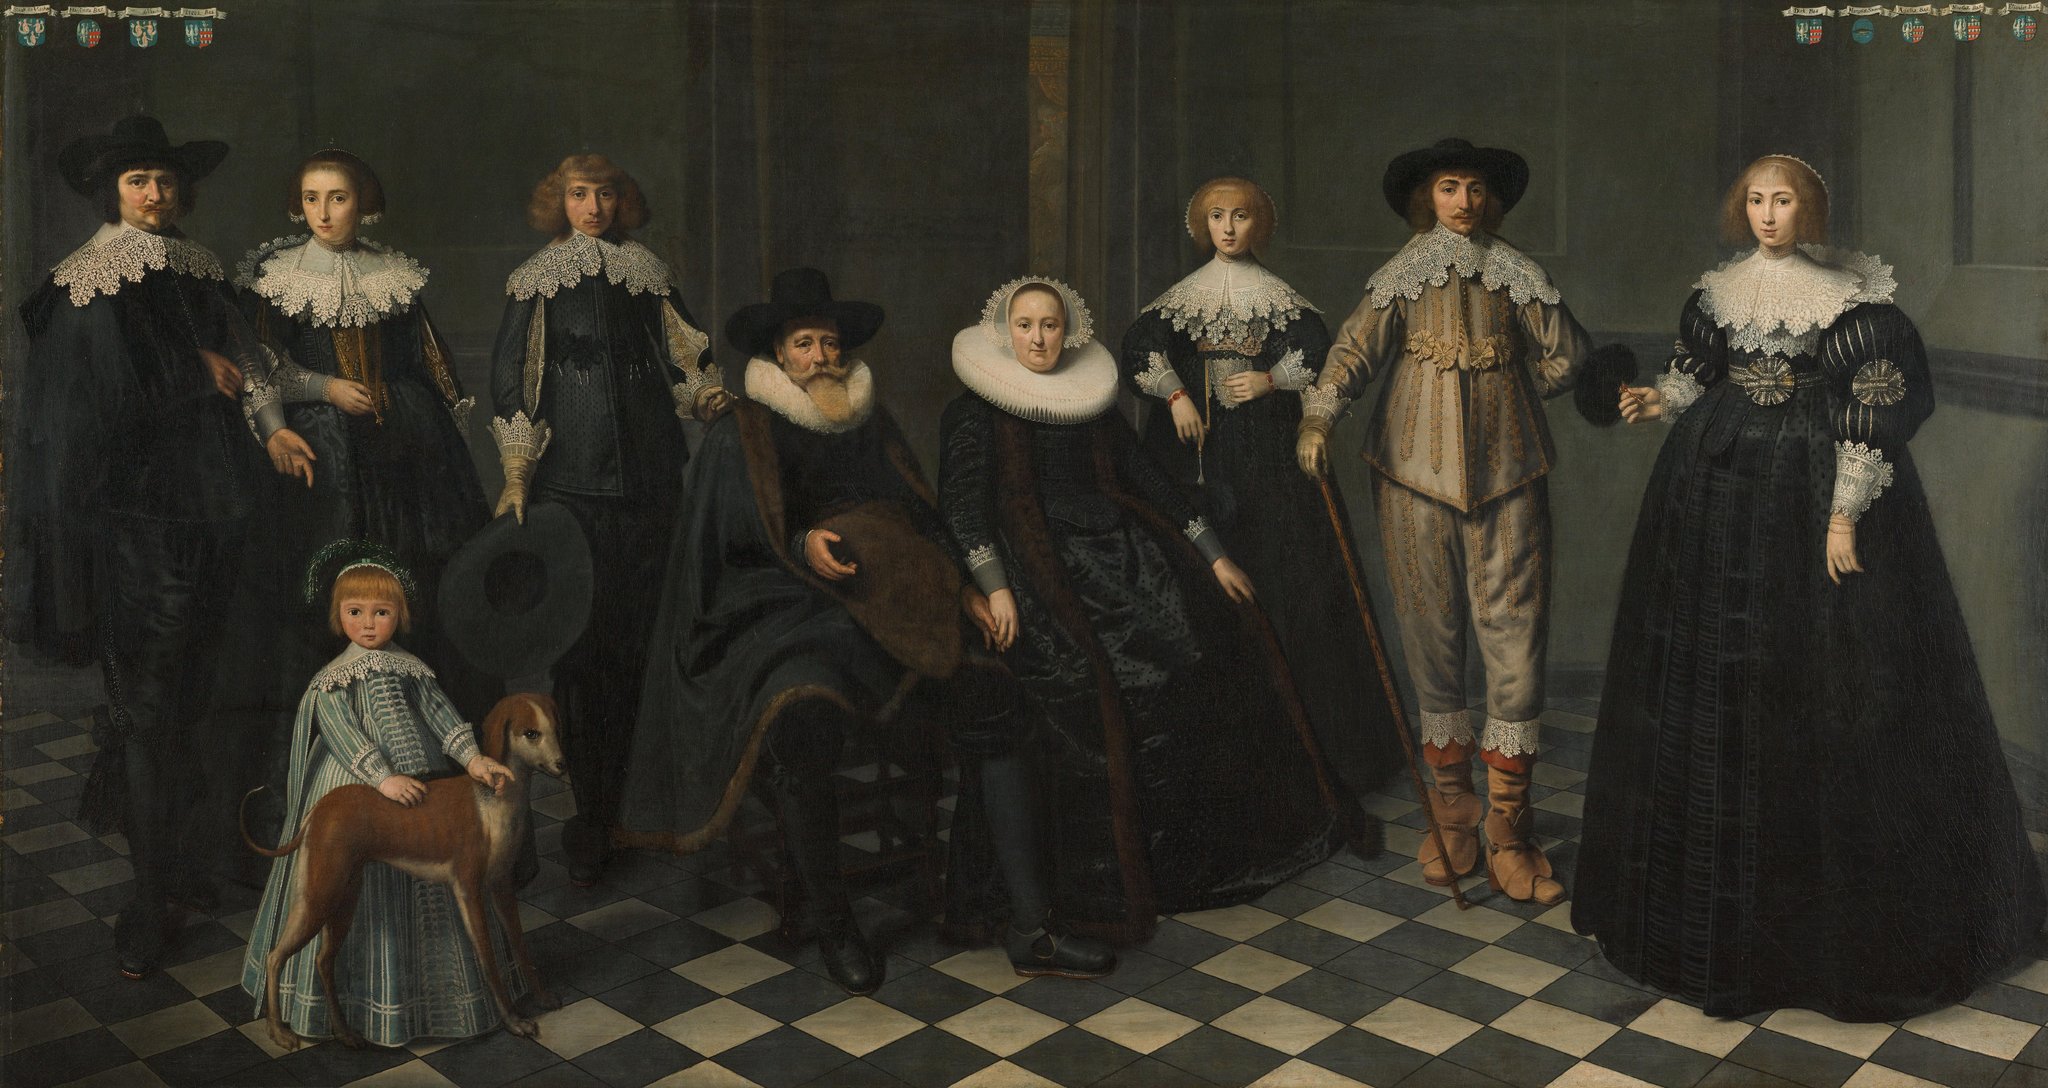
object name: painting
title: Portrait of the Family of Dirck Jacobsz Bas (1569-1637), Burgomaster of Amsterdam, and Margriet Snoeck (1588-1645)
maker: dirck van santvoort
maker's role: draughtsman, painter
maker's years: 1610-1680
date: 1634-1635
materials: canvas, oil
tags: amsterdam, mayor, mayor, burgomaster, historical persons - bb - woman, family group, especially parents with their child(ren), historical persons, dog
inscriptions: inscription, on the banderoles above the coats of arms, top right: ‘5 Dirk. Bas / 6 Margriet. Snoek / 7 Agatha. Bas. / 8 Nicolas. Bas. / 9 Elisabet. Bas.’, inscription, on the banderoles above the coats of arms, top left: ‘1 Abrah. de Vischer / 2 Magtelda. Bas. / 3 de Vischer / 4 Iacob. Bas.’, coat of arms, top left (2x): three mermaids holding two mirrors, two above one, on a blue field, coat of arms, top right, second from left: canting arms of a pike on a blue field, coat of arms, top left (2x): divided vertically. 1: a silver eagle with an olive branch in its beak on a blue field. 2, divided horizontally: A, a silver stork on a blue field; B, three blue bars strewn with eleven miniature silver escutcheons, alternating with three red bars, coat of arms, top right (4x): divided vertically. 1: a silver eagle with an olive branch in its beak on a blue field. 2, divided horizontally: A, a silver stork on a blue field; B, three blue bars strewn with eleven miniature silver escutcheons, alternating with three red bars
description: Familieportret van het gezin van Dirck Bas Jacobsz, burgemeester van Amsterdam. In het midden zit Dirck Bas Jacobsz (1569-1637) met zijn tweede echtgenote Margriet Snoeck (1588-1645). De kinderen zijn staand ten voeten uit voorgesteld (van links naar rechts): Machteld Bas (gest. 1681) met haar man Abraham de Visscher (1605-1667) en hun zoontje met een hond, Jacob Bas Dircksz (1609-1656), Agatha Bas (1611-1658), Claes Bas (1616-1635) en Lysbeth Bas (1619-1680). Rechts- en linksboven staan de familiewapens met namen.